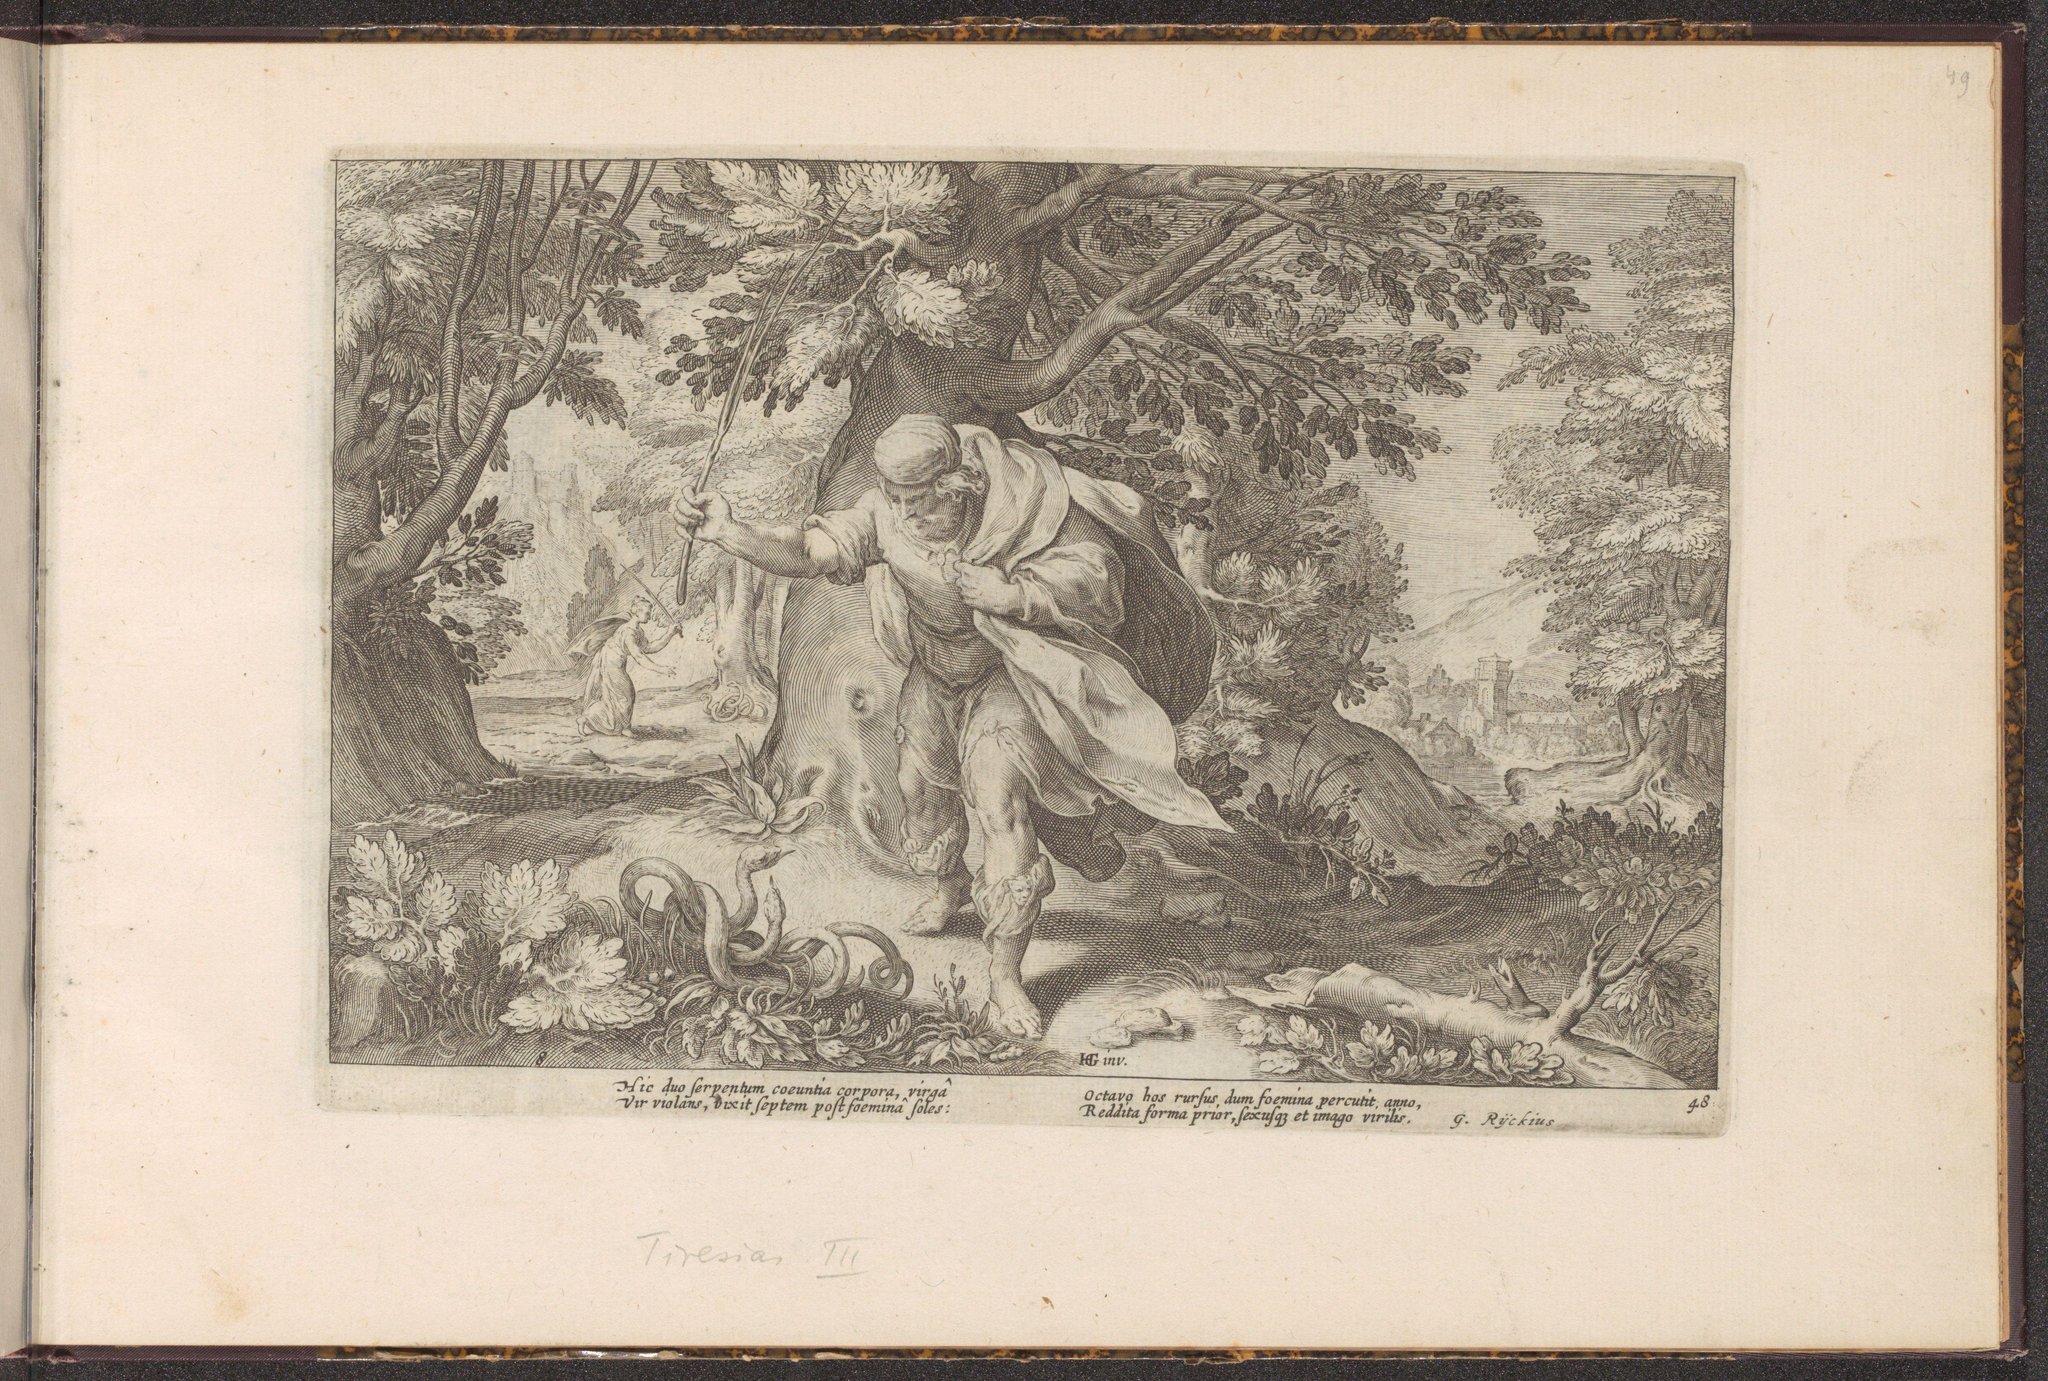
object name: album leaf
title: Ovidius' Metamorfosen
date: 1615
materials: paper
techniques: engraving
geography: amsterdam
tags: seven years later, by the same action, tiresias turns into a man again, tiresias, striking two coupling serpents with his staff, is changed into a woman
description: Tiresias slaat in een bos twee parende slangen. Daarop verandert hij in een vrouw. Op de achtergrond slaat hij acht herfsten later dezelfde slangen in de gedaante van een vrouw, om terug te veranderen naar zijn mannenlichaam. Onder de voorstelling twee keer twee versregels in het Latijn. De prent maakt deel uit van een album.